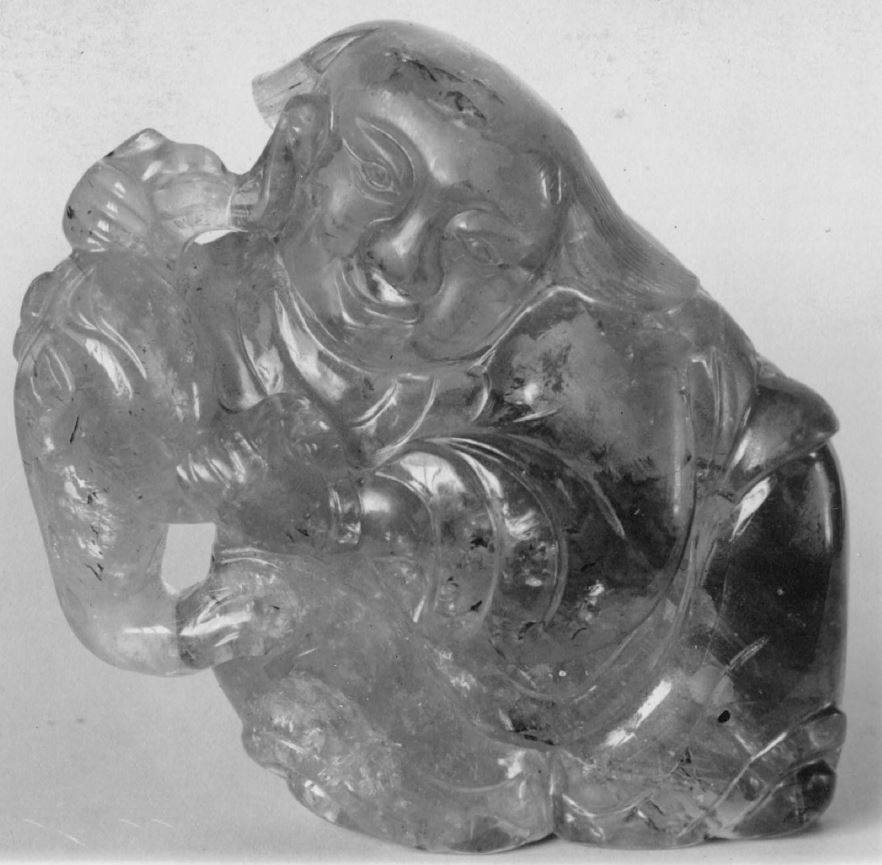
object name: ornament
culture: chinese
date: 1736-1795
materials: gemstone, quartz